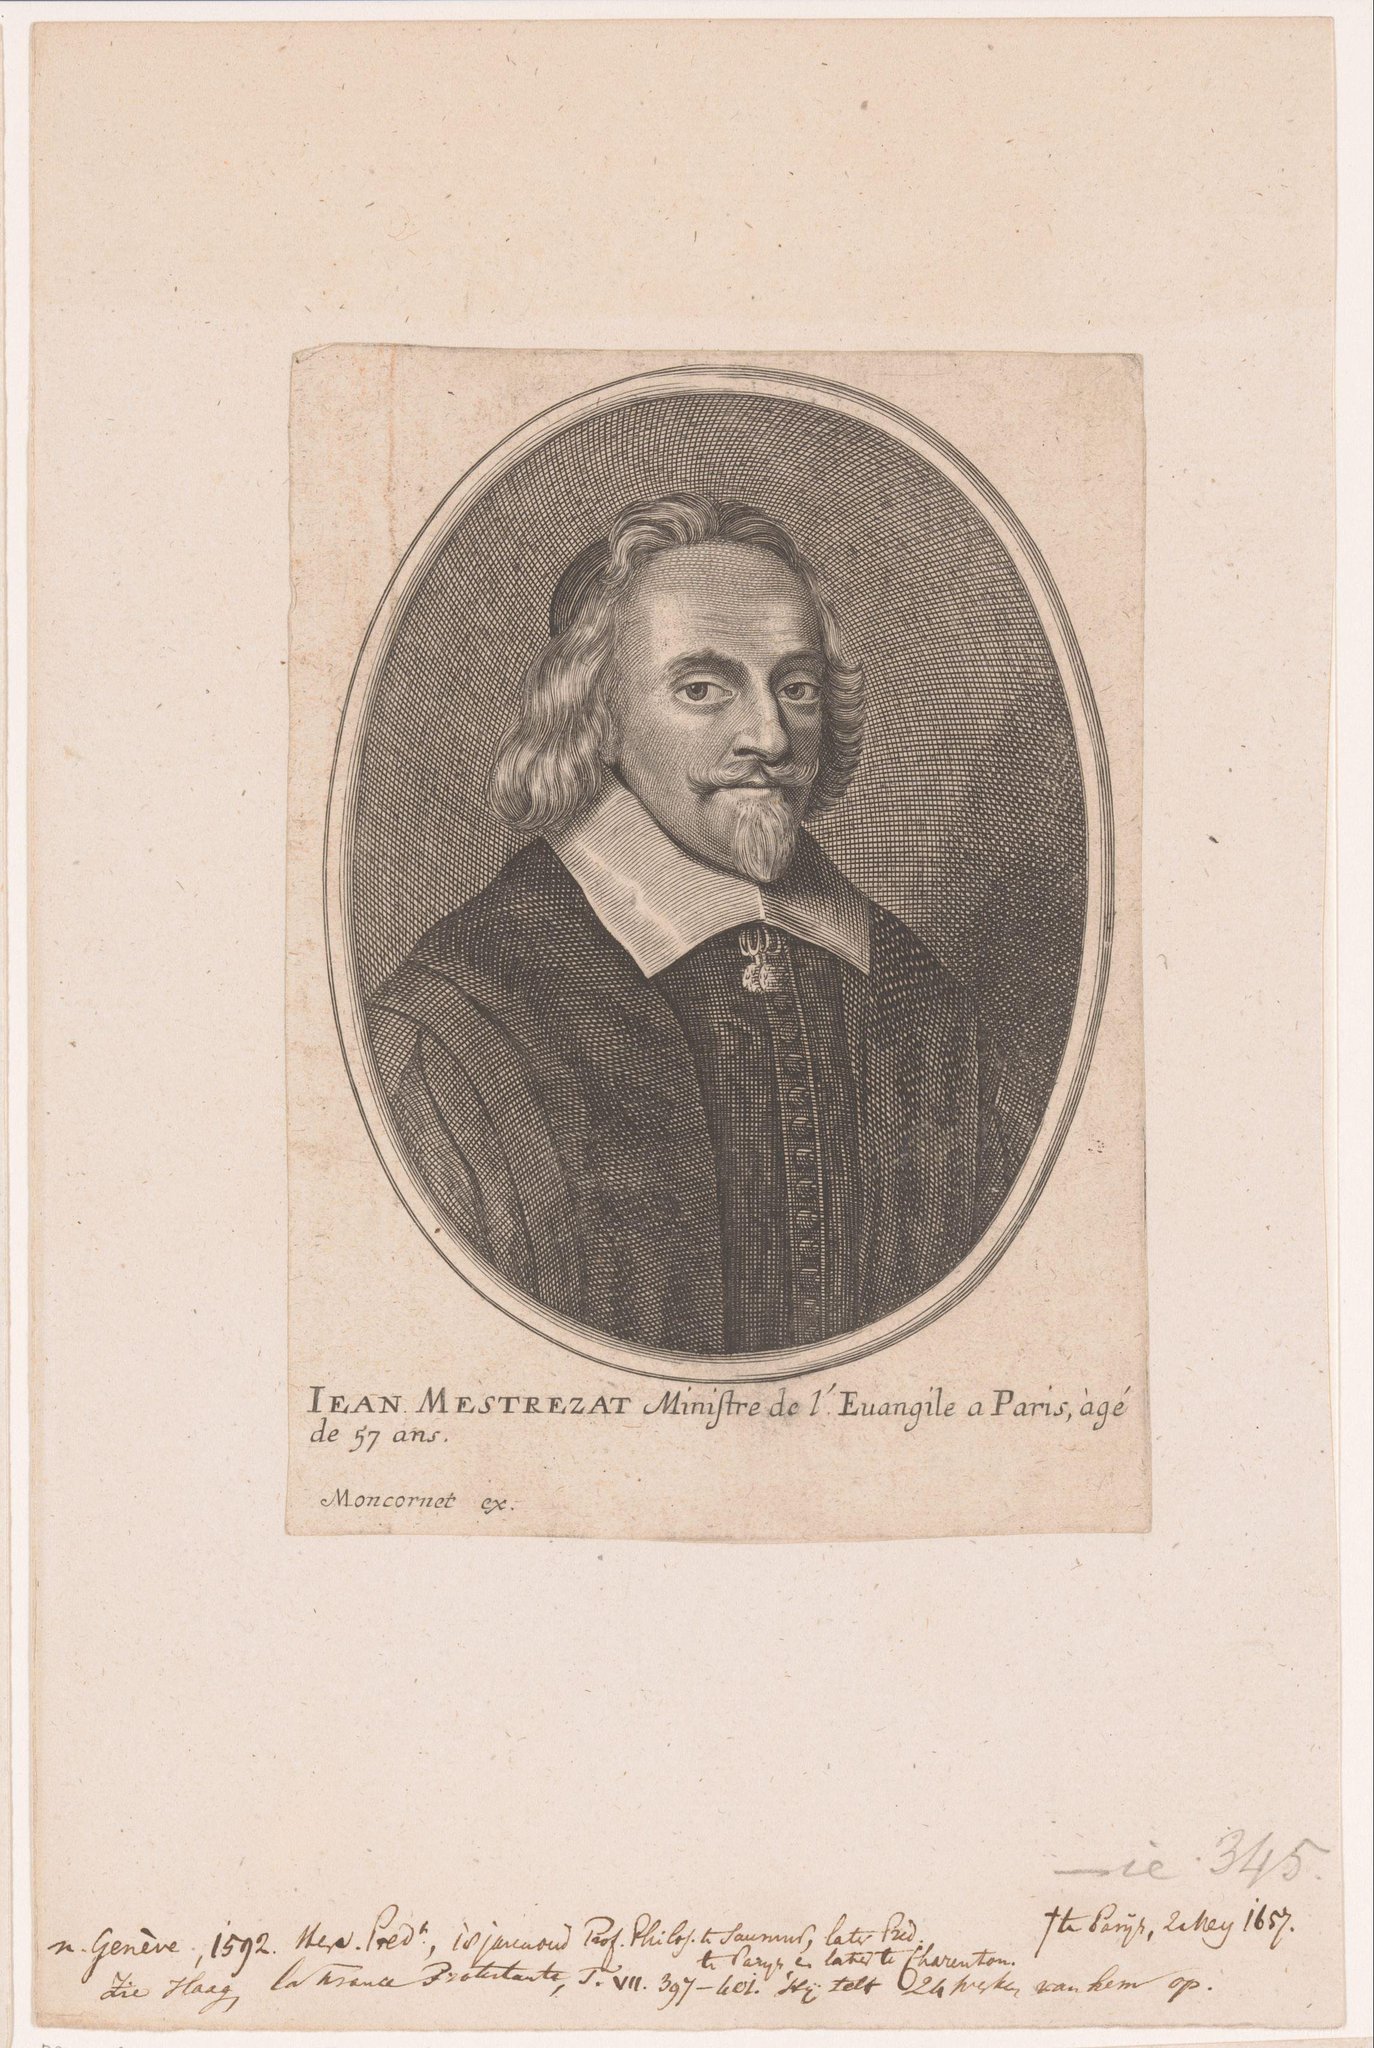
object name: print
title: Portret van Jean Mestrezat op 57-jarige leeftijd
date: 1649-1668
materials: paper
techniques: engraving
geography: paris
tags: paris, theologian, historical persons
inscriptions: collector's mark: Lugt 2228